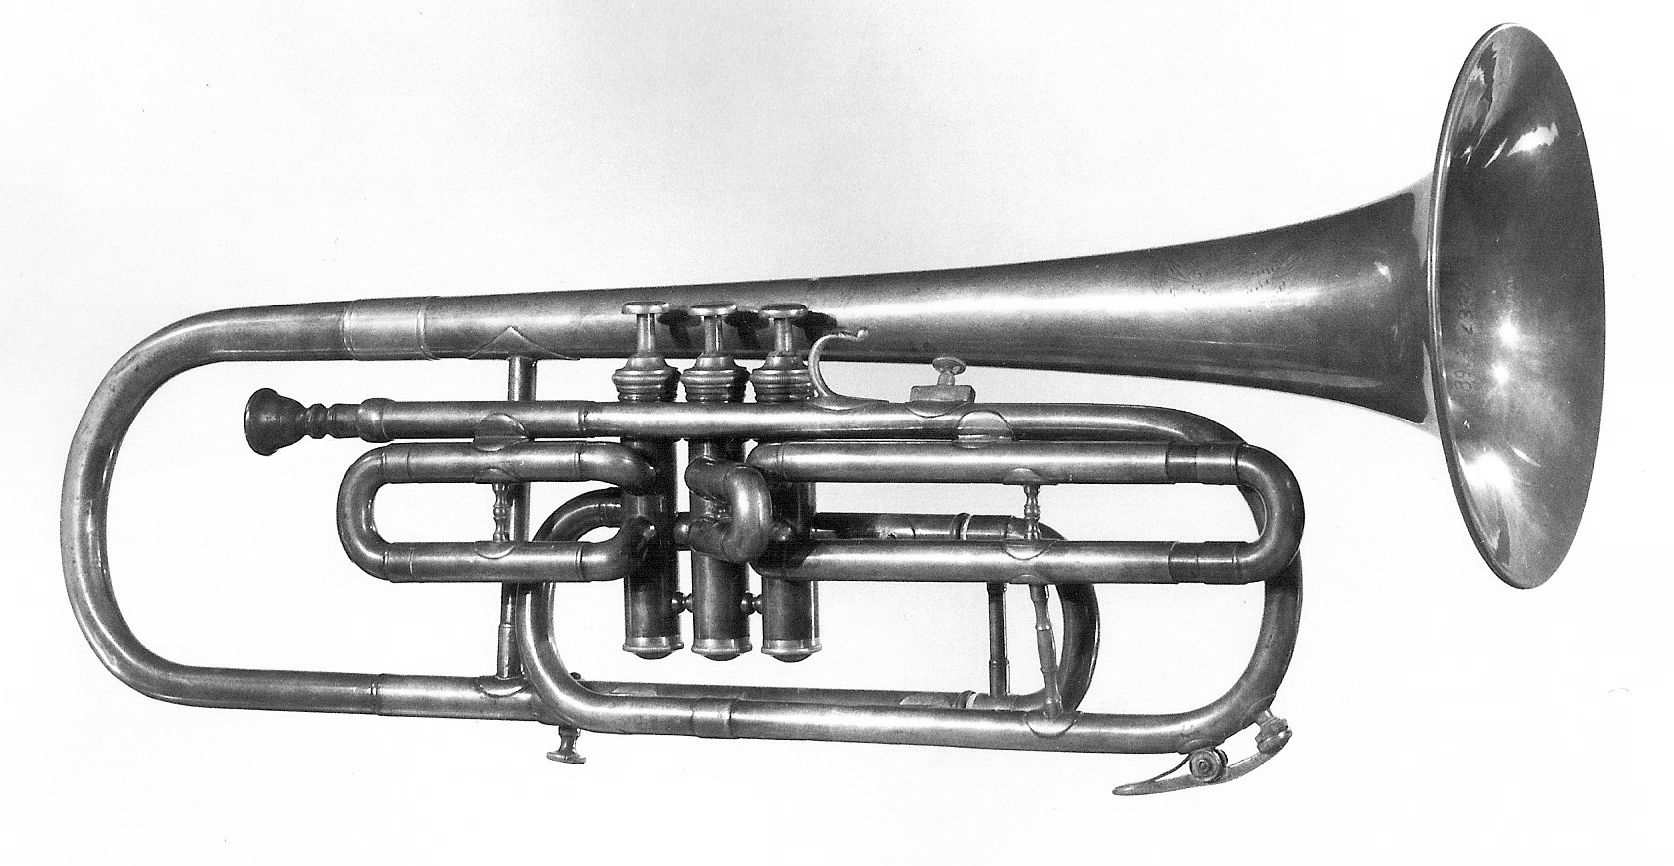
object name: bass valve trombone in e flat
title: Alto valve trombone in E-flat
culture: american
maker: august pollmann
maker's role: maker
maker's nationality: american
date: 1834-1866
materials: brass, nickel, silver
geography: united states